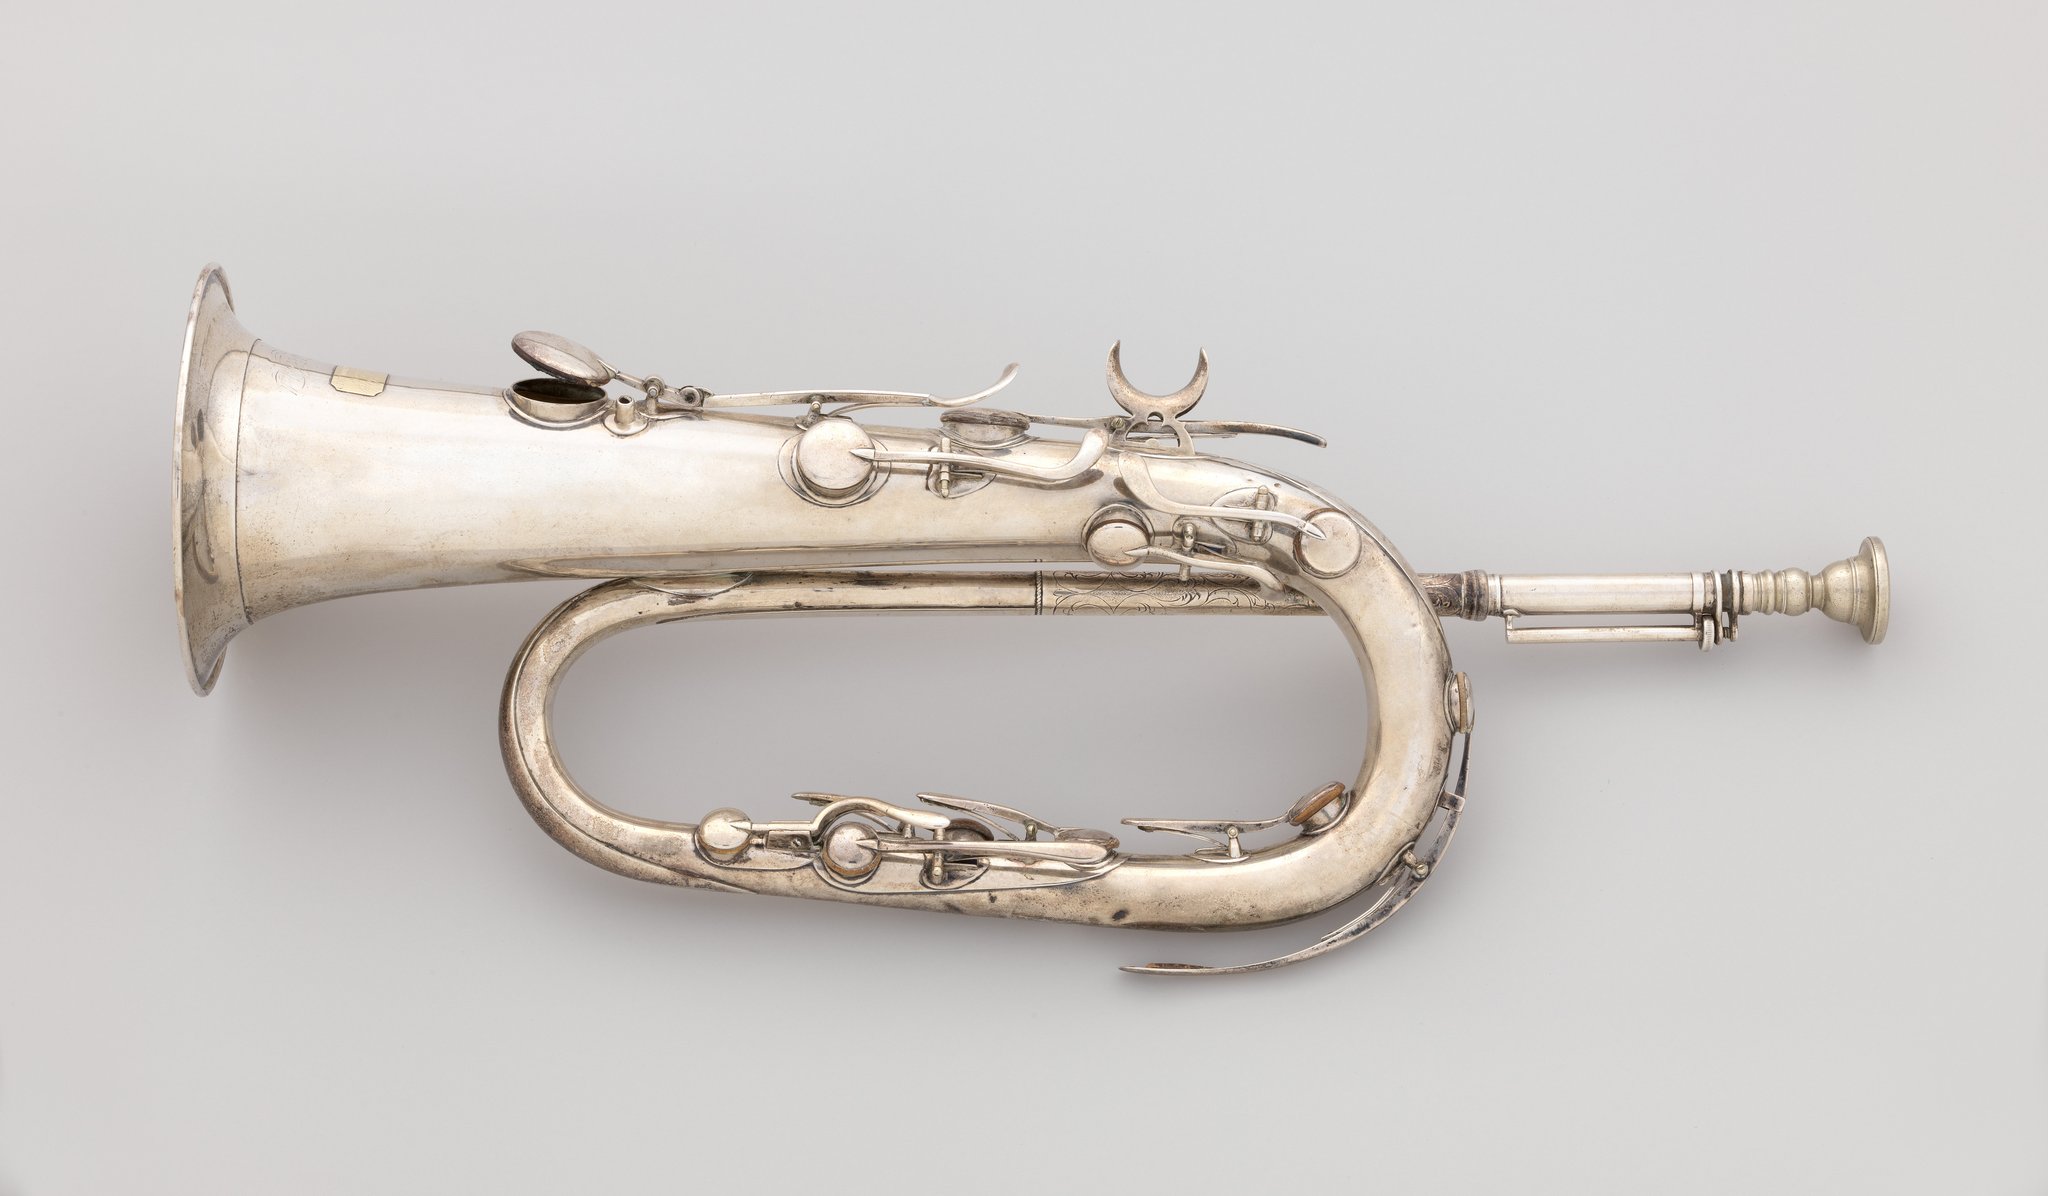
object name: keyed bugle in e flat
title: Keyed bugle in E-flat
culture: american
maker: henry sibley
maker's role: maker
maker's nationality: american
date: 1840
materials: silver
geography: united states